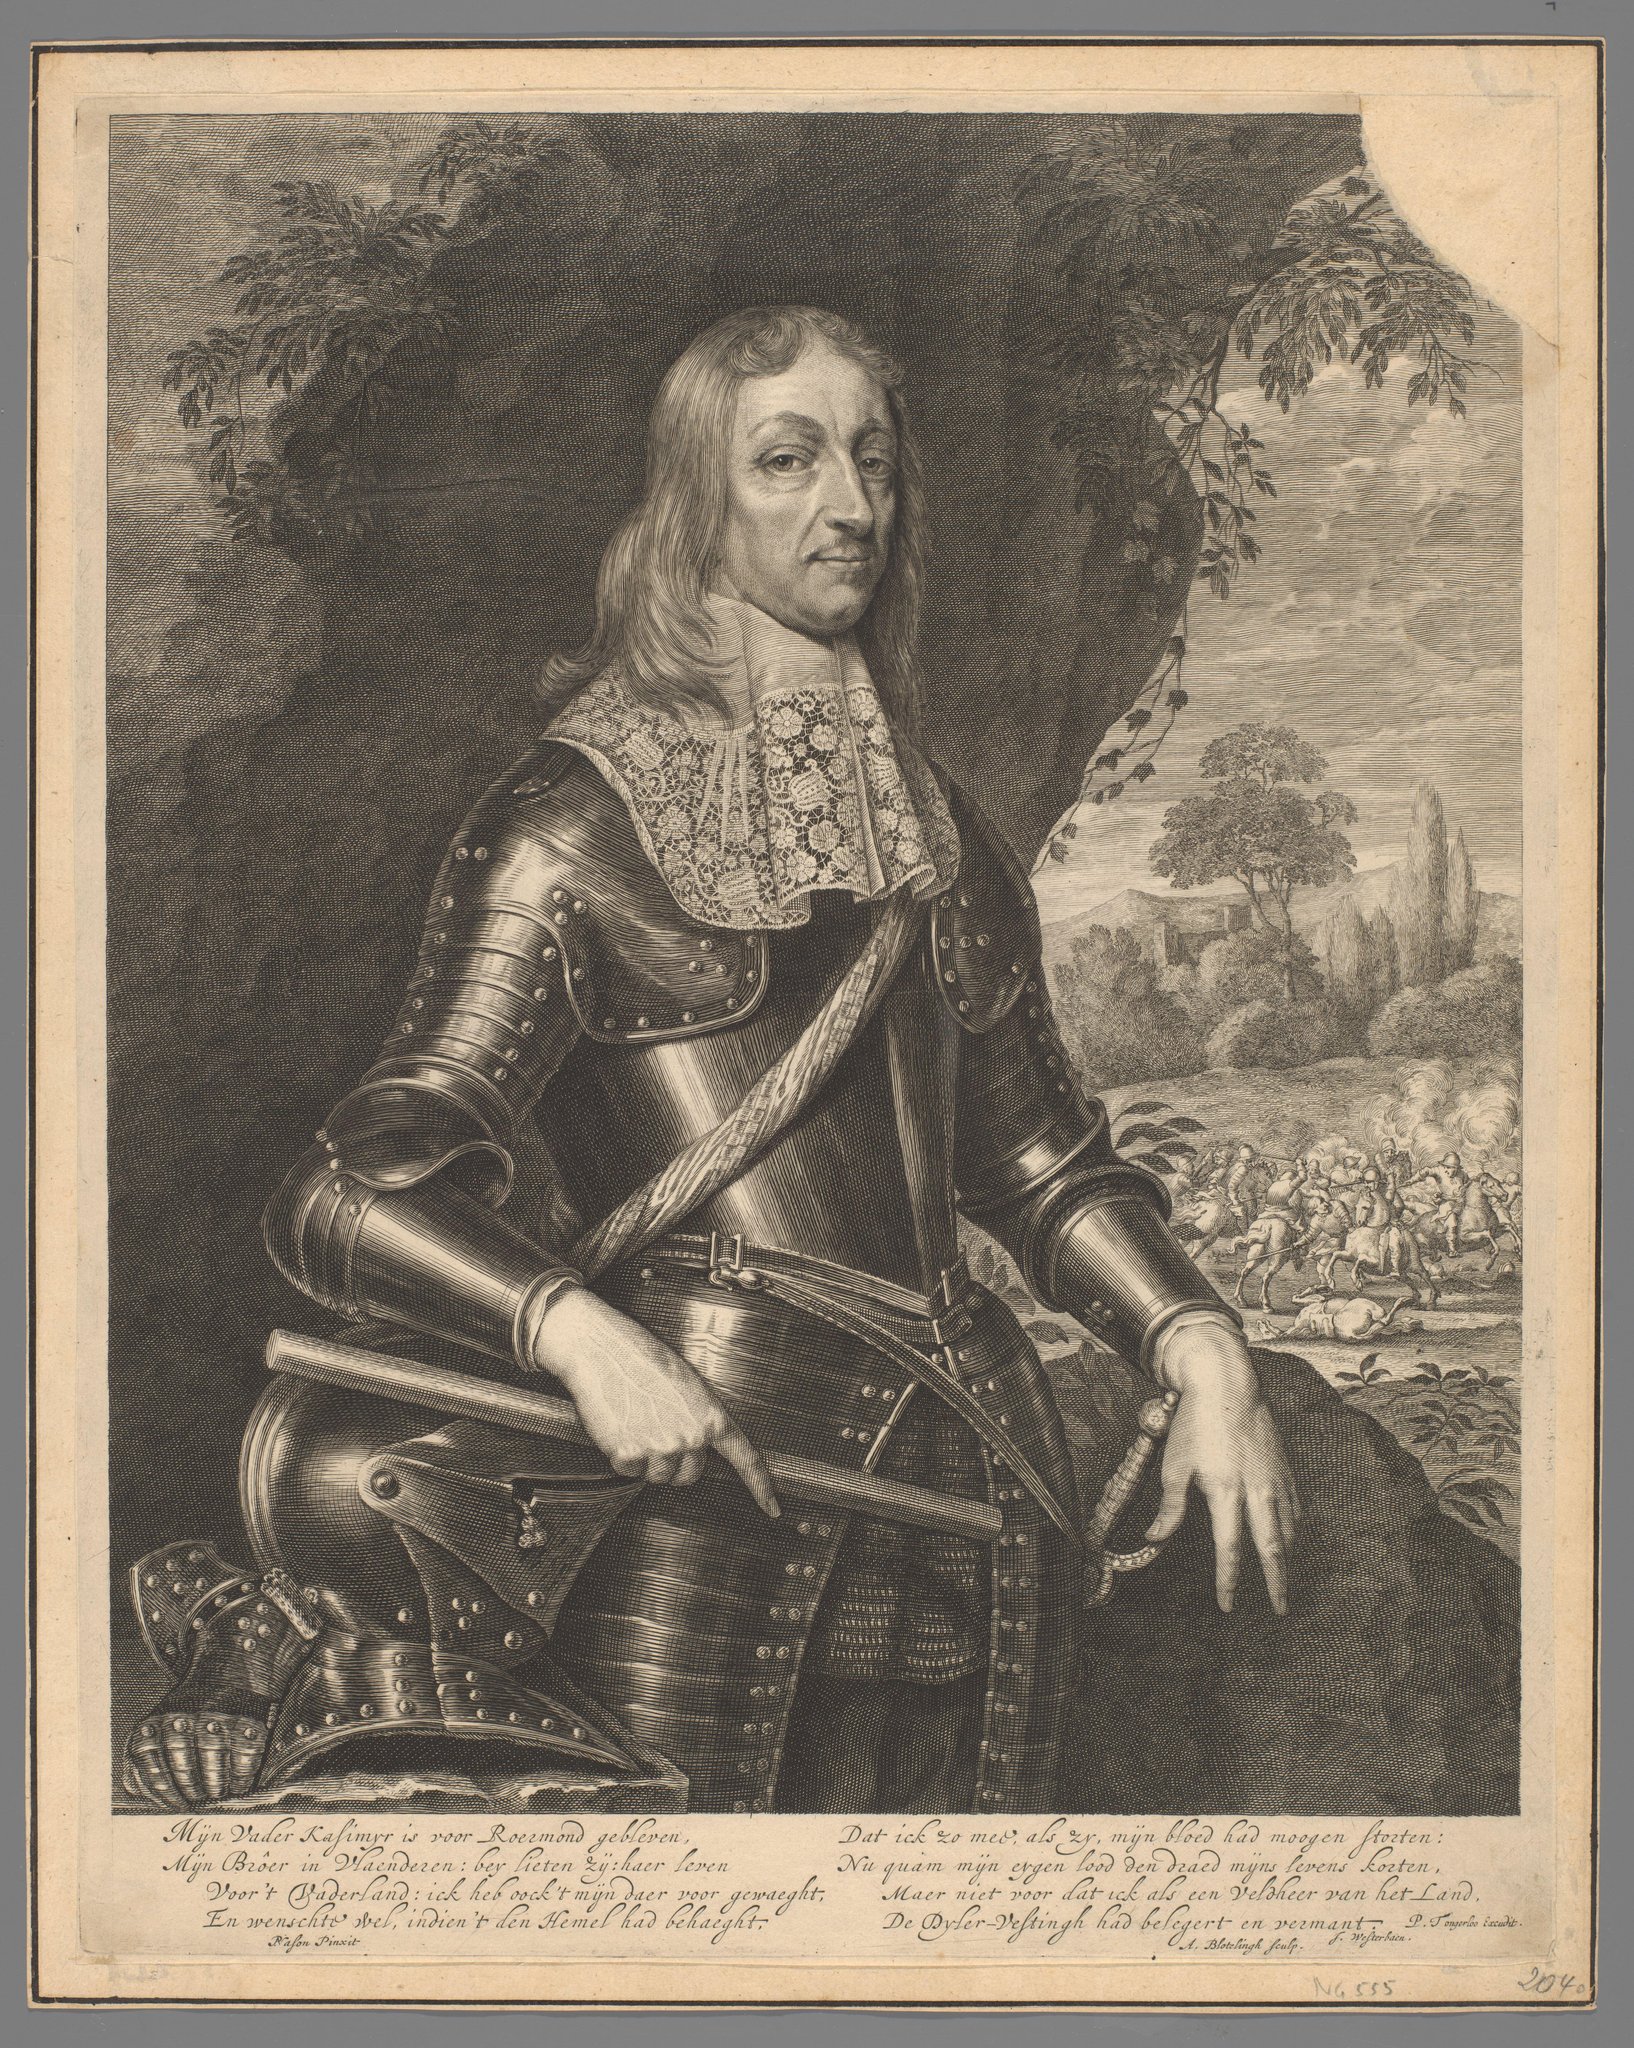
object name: print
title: Portret van Willem Frederik, graaf van Nassau-Dietz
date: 1682-1707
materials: paper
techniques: engraving, etching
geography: the hague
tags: arnhem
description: Portret van Willem Frederik. In zijn rechterhand een commandostaf. Op de achtergrond een ruitergevecht. In de ondermarge twee kolommen met elk vier regels Nederlandse tekst.